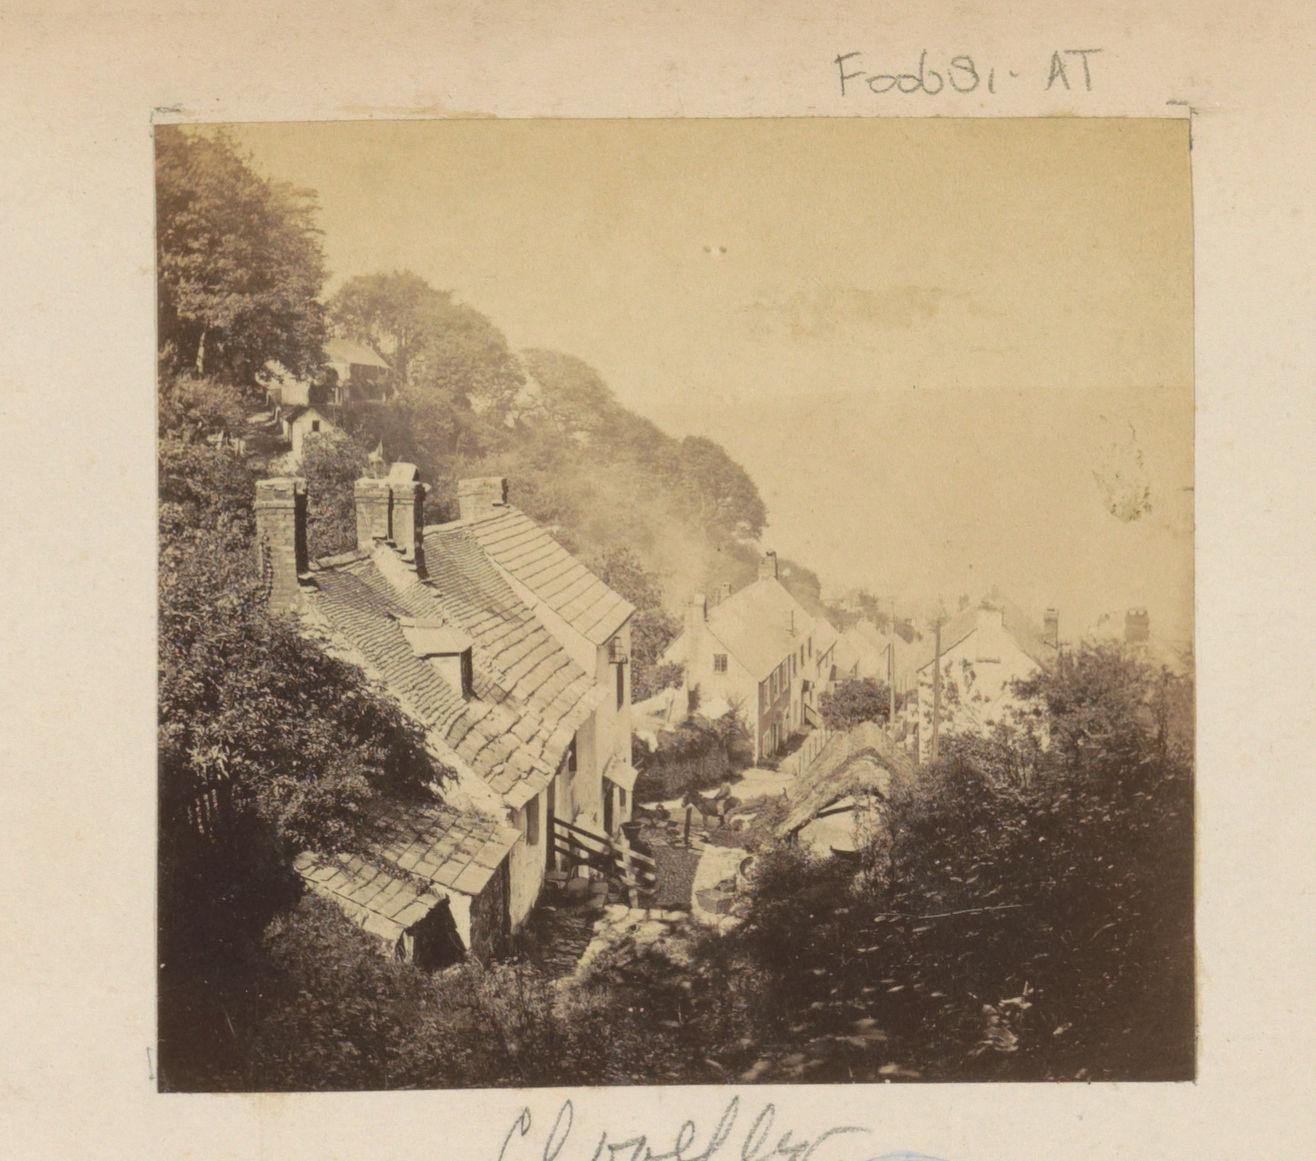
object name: photograph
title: Gezicht op Clovelly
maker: Anonymous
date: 1850-1870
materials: paper, photographic support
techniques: albumen print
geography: clovelly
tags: prospect of village, silhouette of village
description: Onderdeel van Album met foto's van bezienswaardigheden en landschappen in Engeland en van kunst.